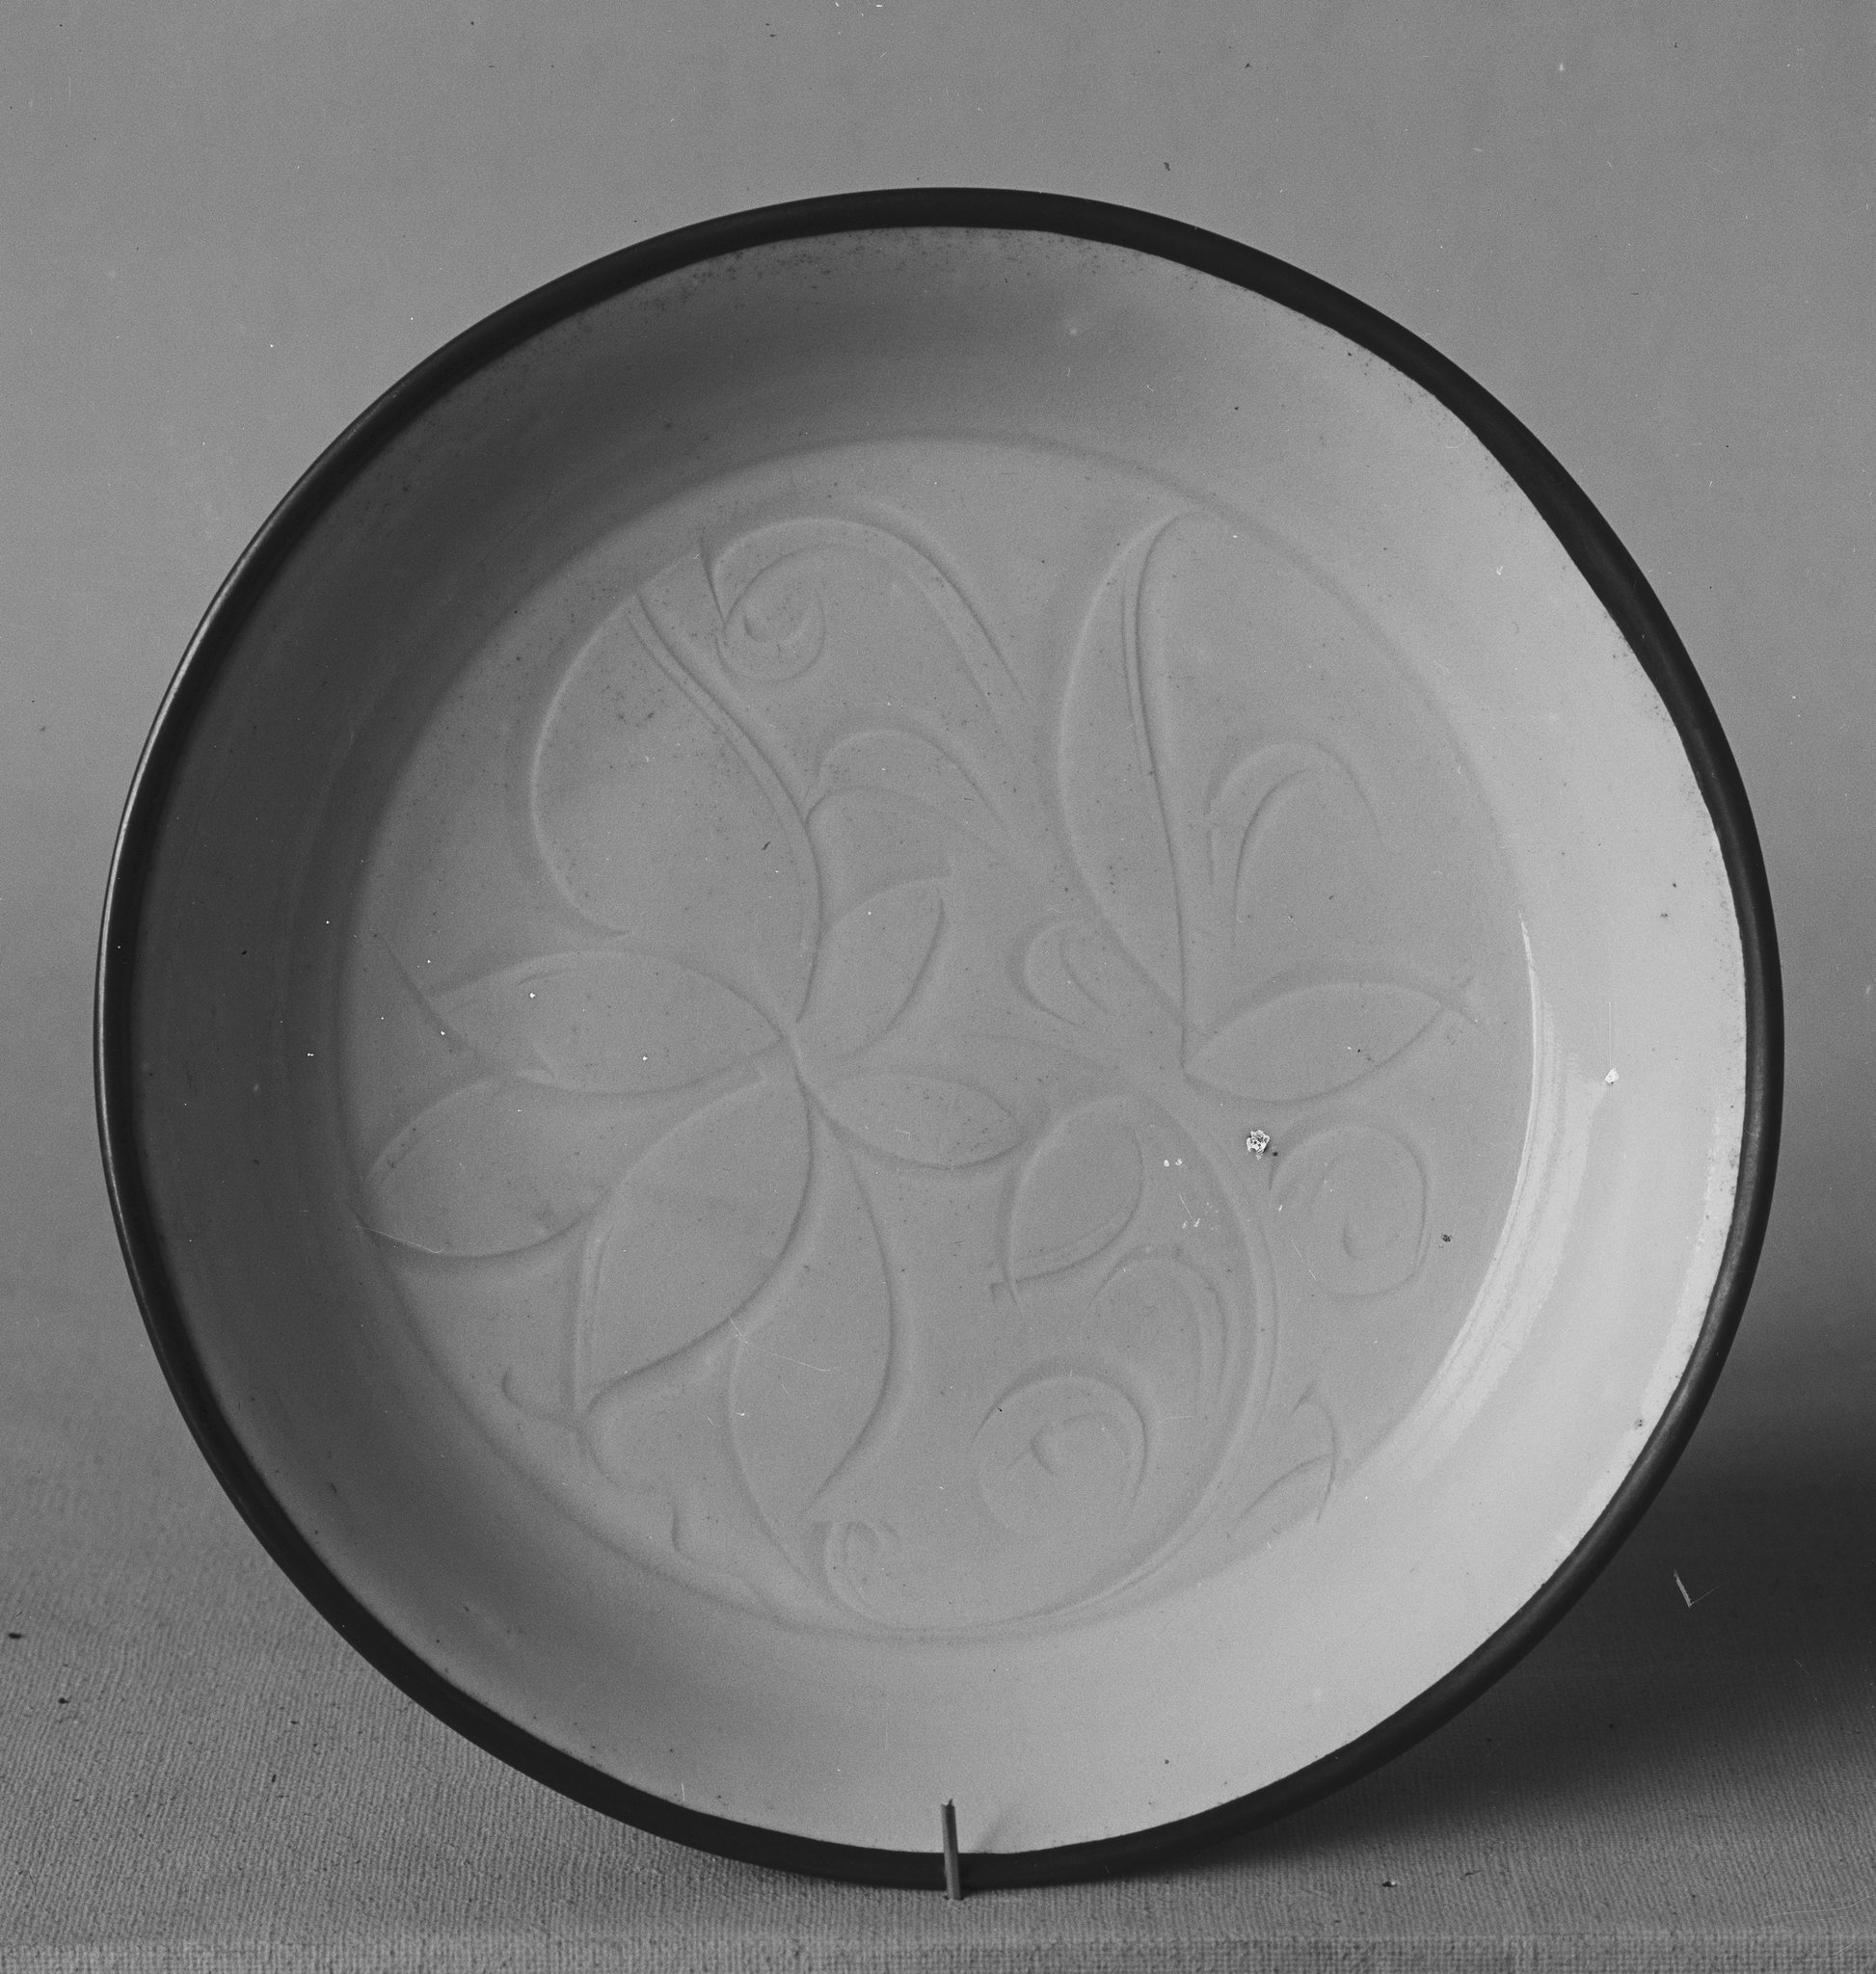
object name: saucer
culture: chinese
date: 960-1127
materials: pottery